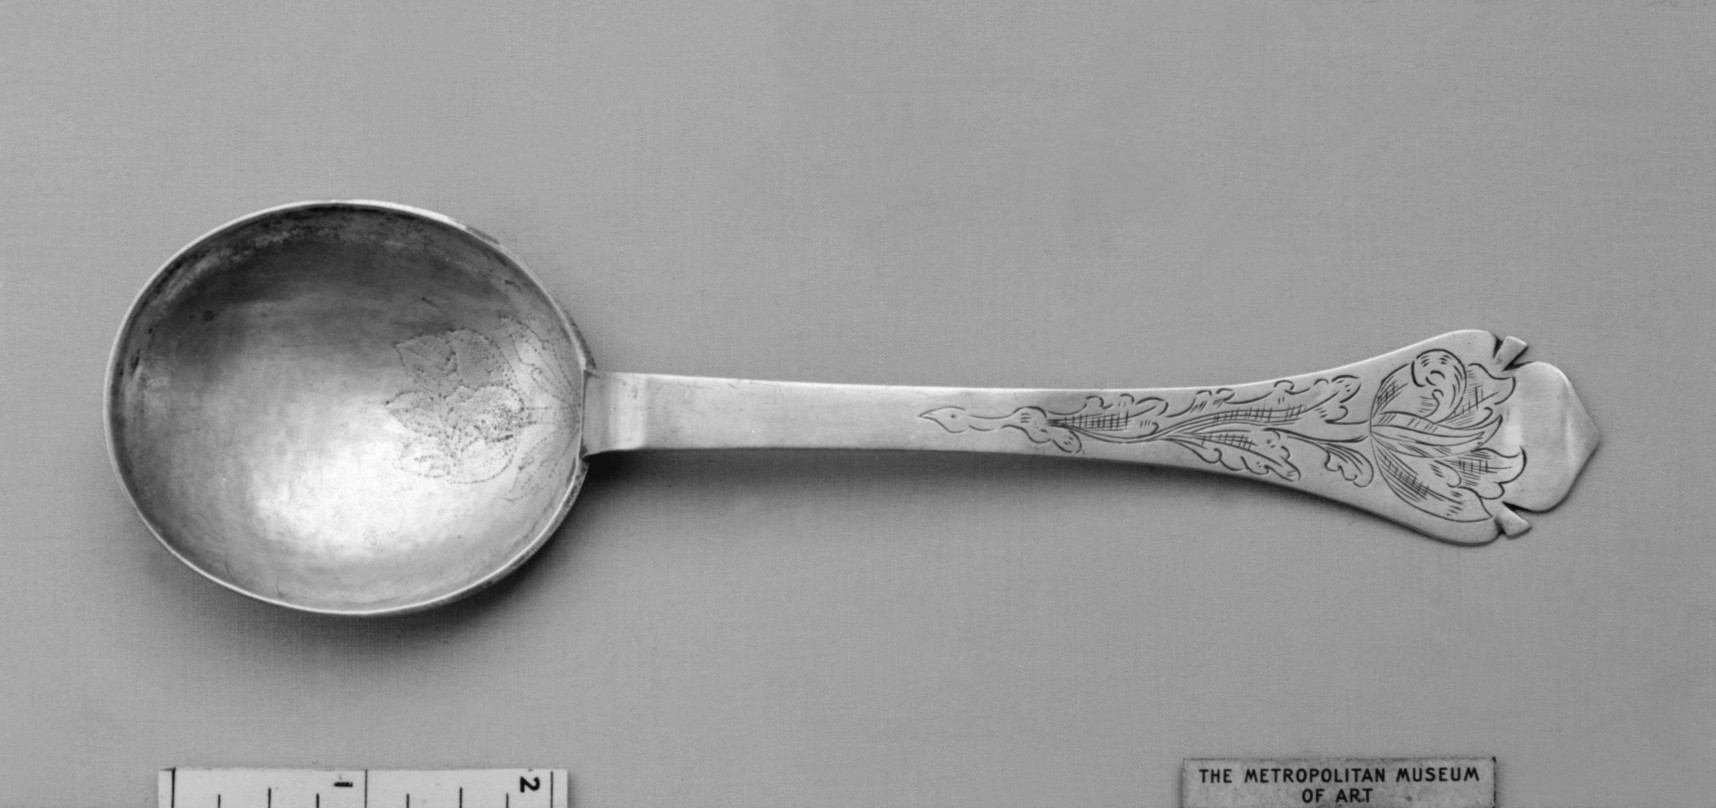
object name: spoon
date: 1701-1800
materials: silver